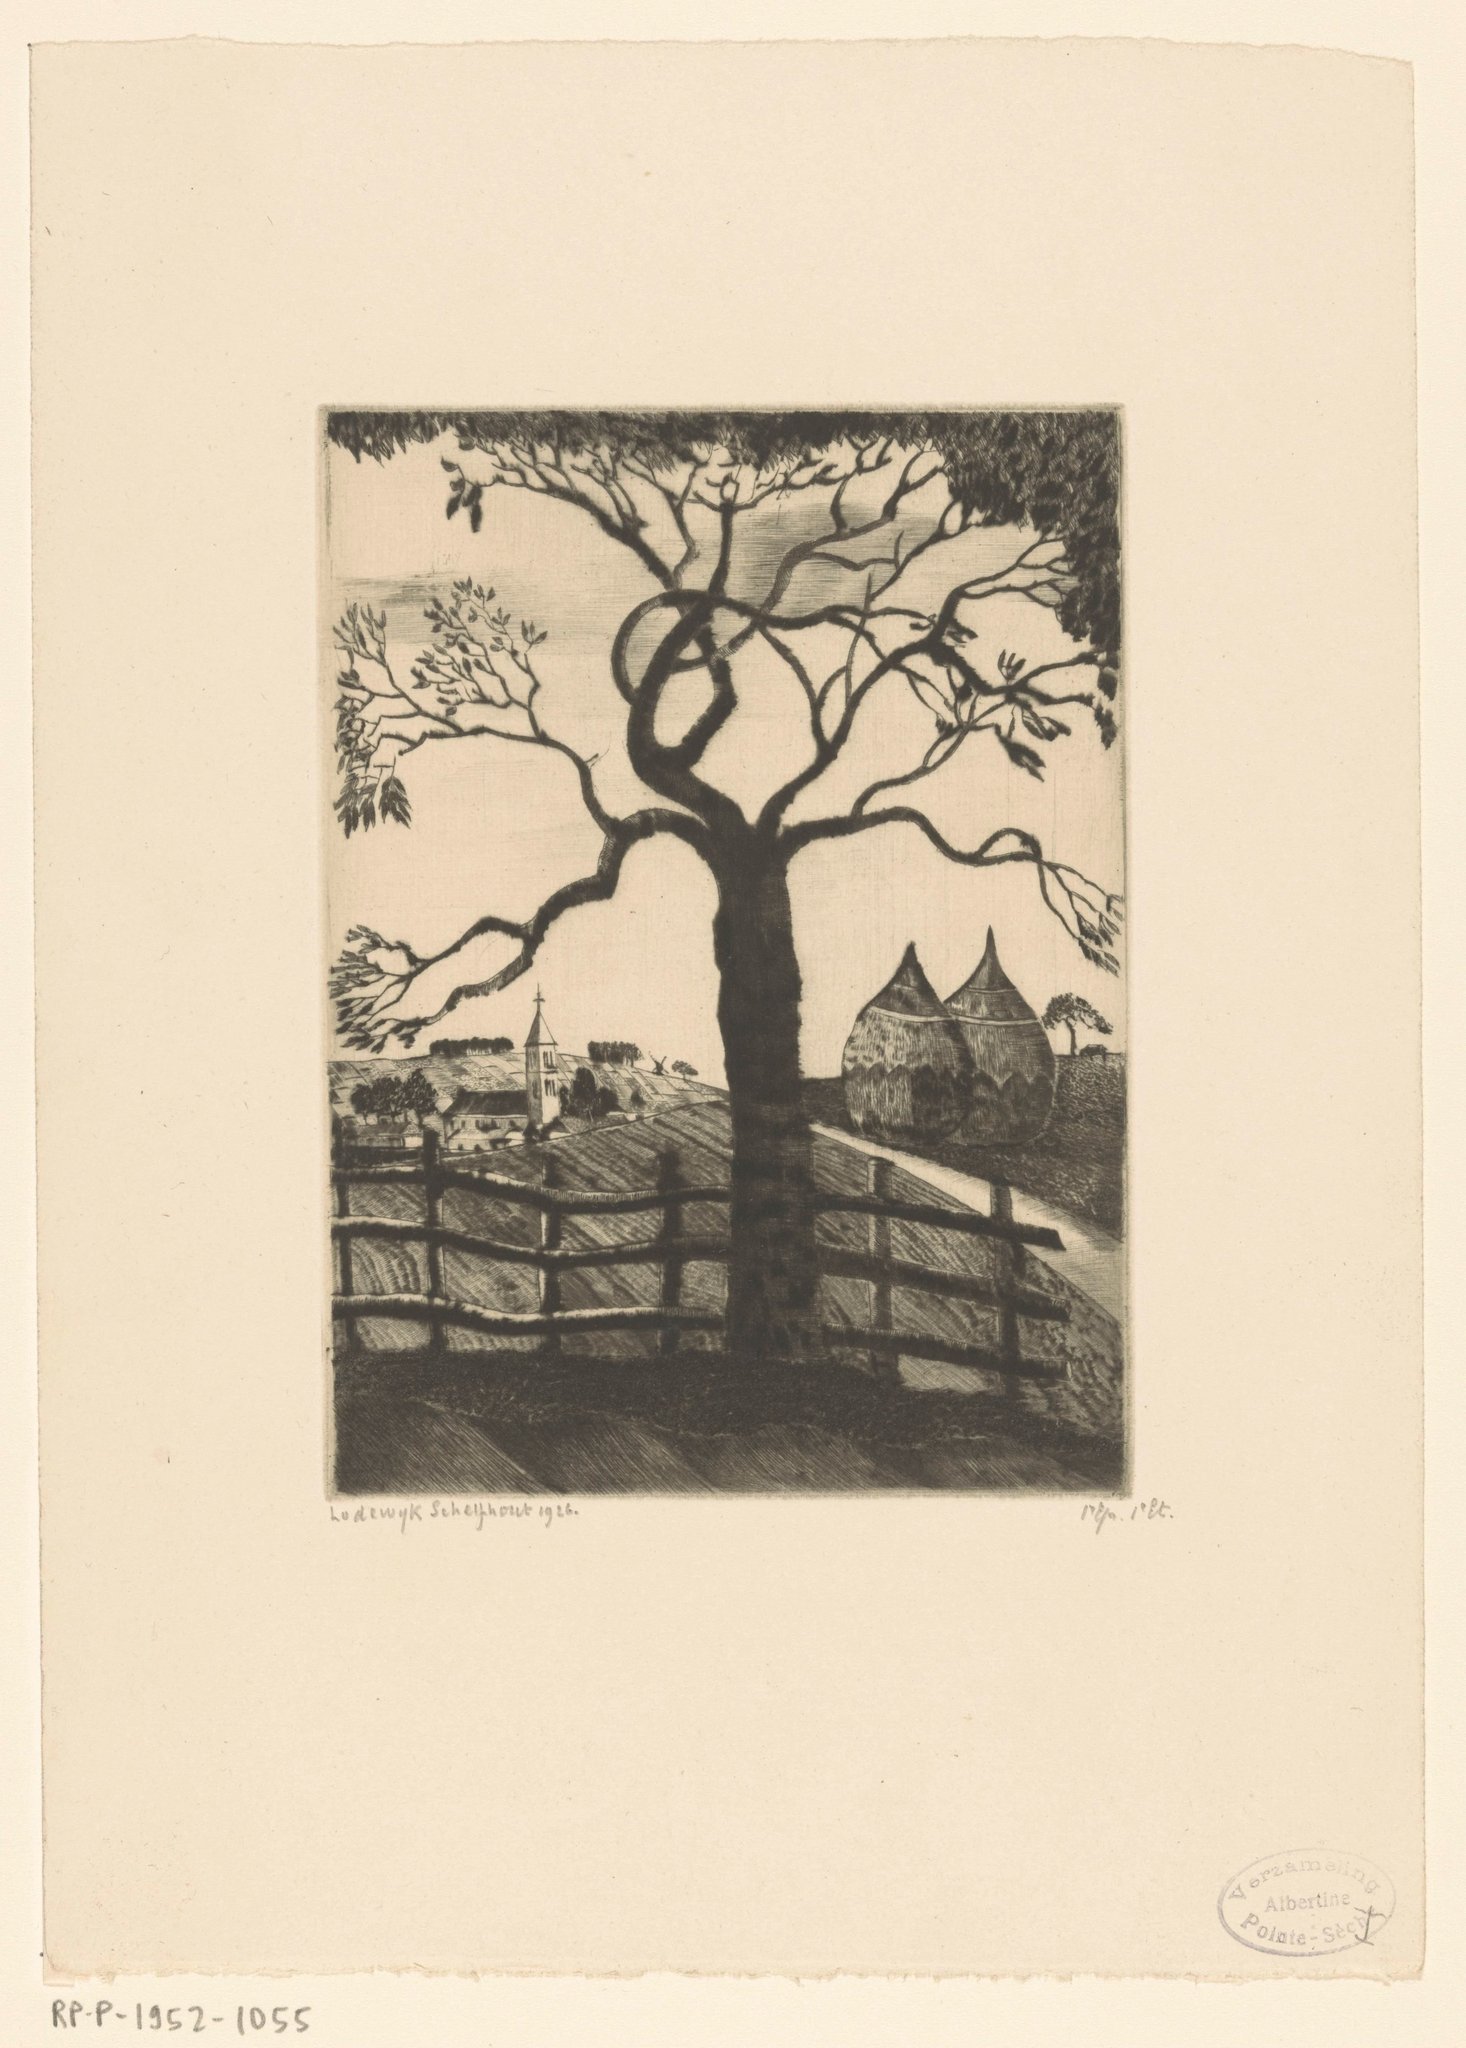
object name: print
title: Etichove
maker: lodewijk schelfhout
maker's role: draughtsman, print maker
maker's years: 1881-1943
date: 1926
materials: paper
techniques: drypoint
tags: low hill country, trees, church (exterior)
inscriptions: collector's mark: Lugt 5i, collector's mark: Lugt 2228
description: Het heuvellandschap bij de plaats Etikhove in de Belgische provincie Oost-Vlaanderen. Op de voorgrond een boom, een hek en twee hooischelven. Op de achtergrond een kerk.